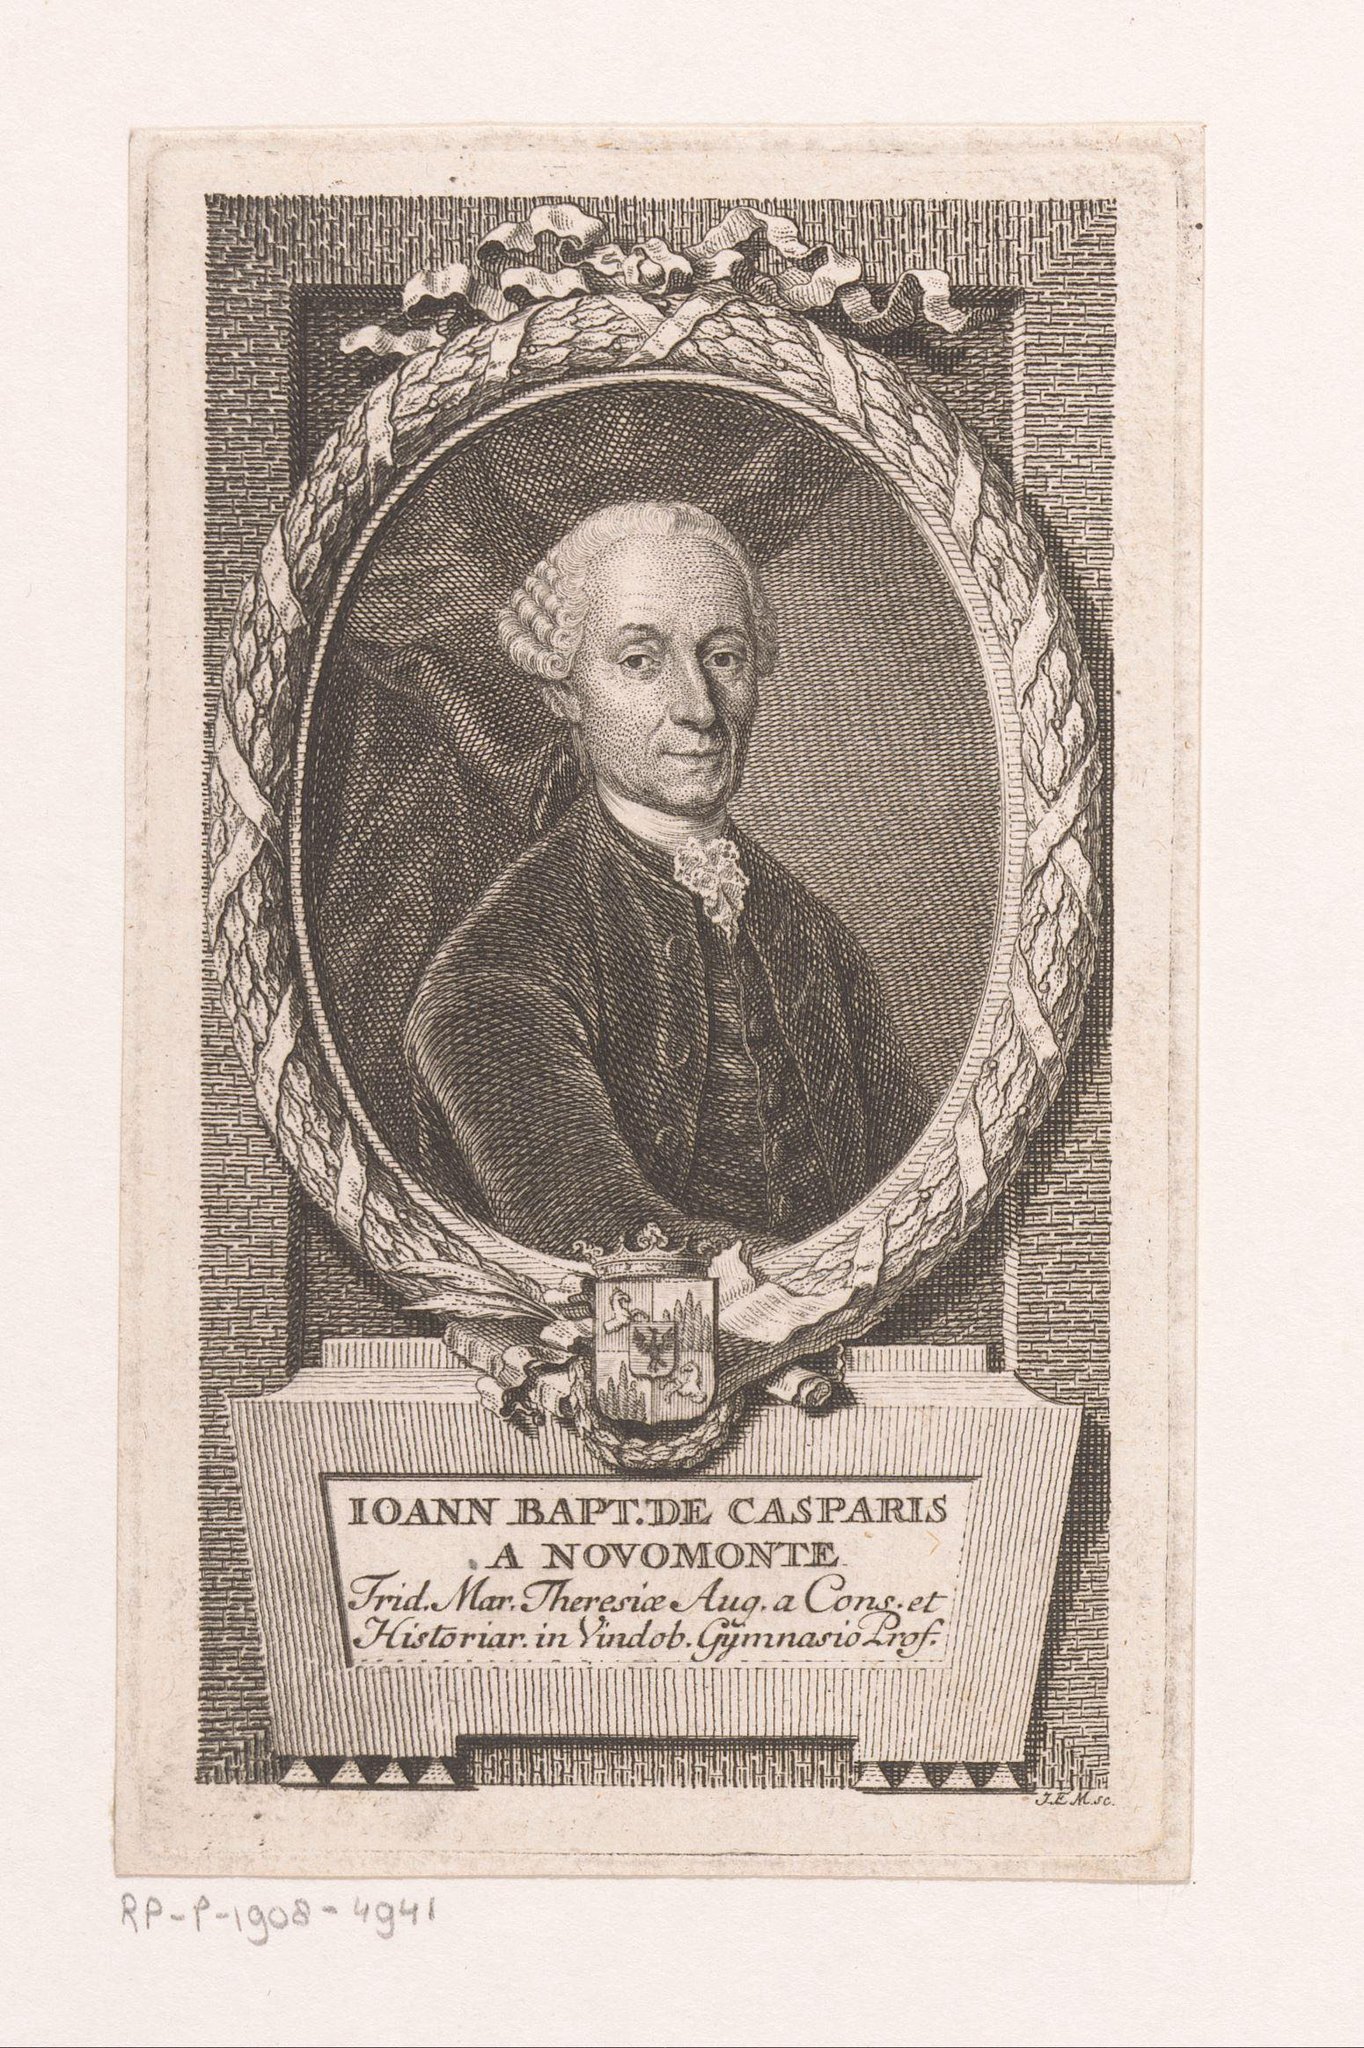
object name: print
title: Portret van Giovanni Battista de Gaspari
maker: johann ernst mansfeld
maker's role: print maker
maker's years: 1739-1796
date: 1749-1796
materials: paper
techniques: engraving, etching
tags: vienna, historical persons, armorial bearing, heraldry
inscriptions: collector's mark: Lugt 2228